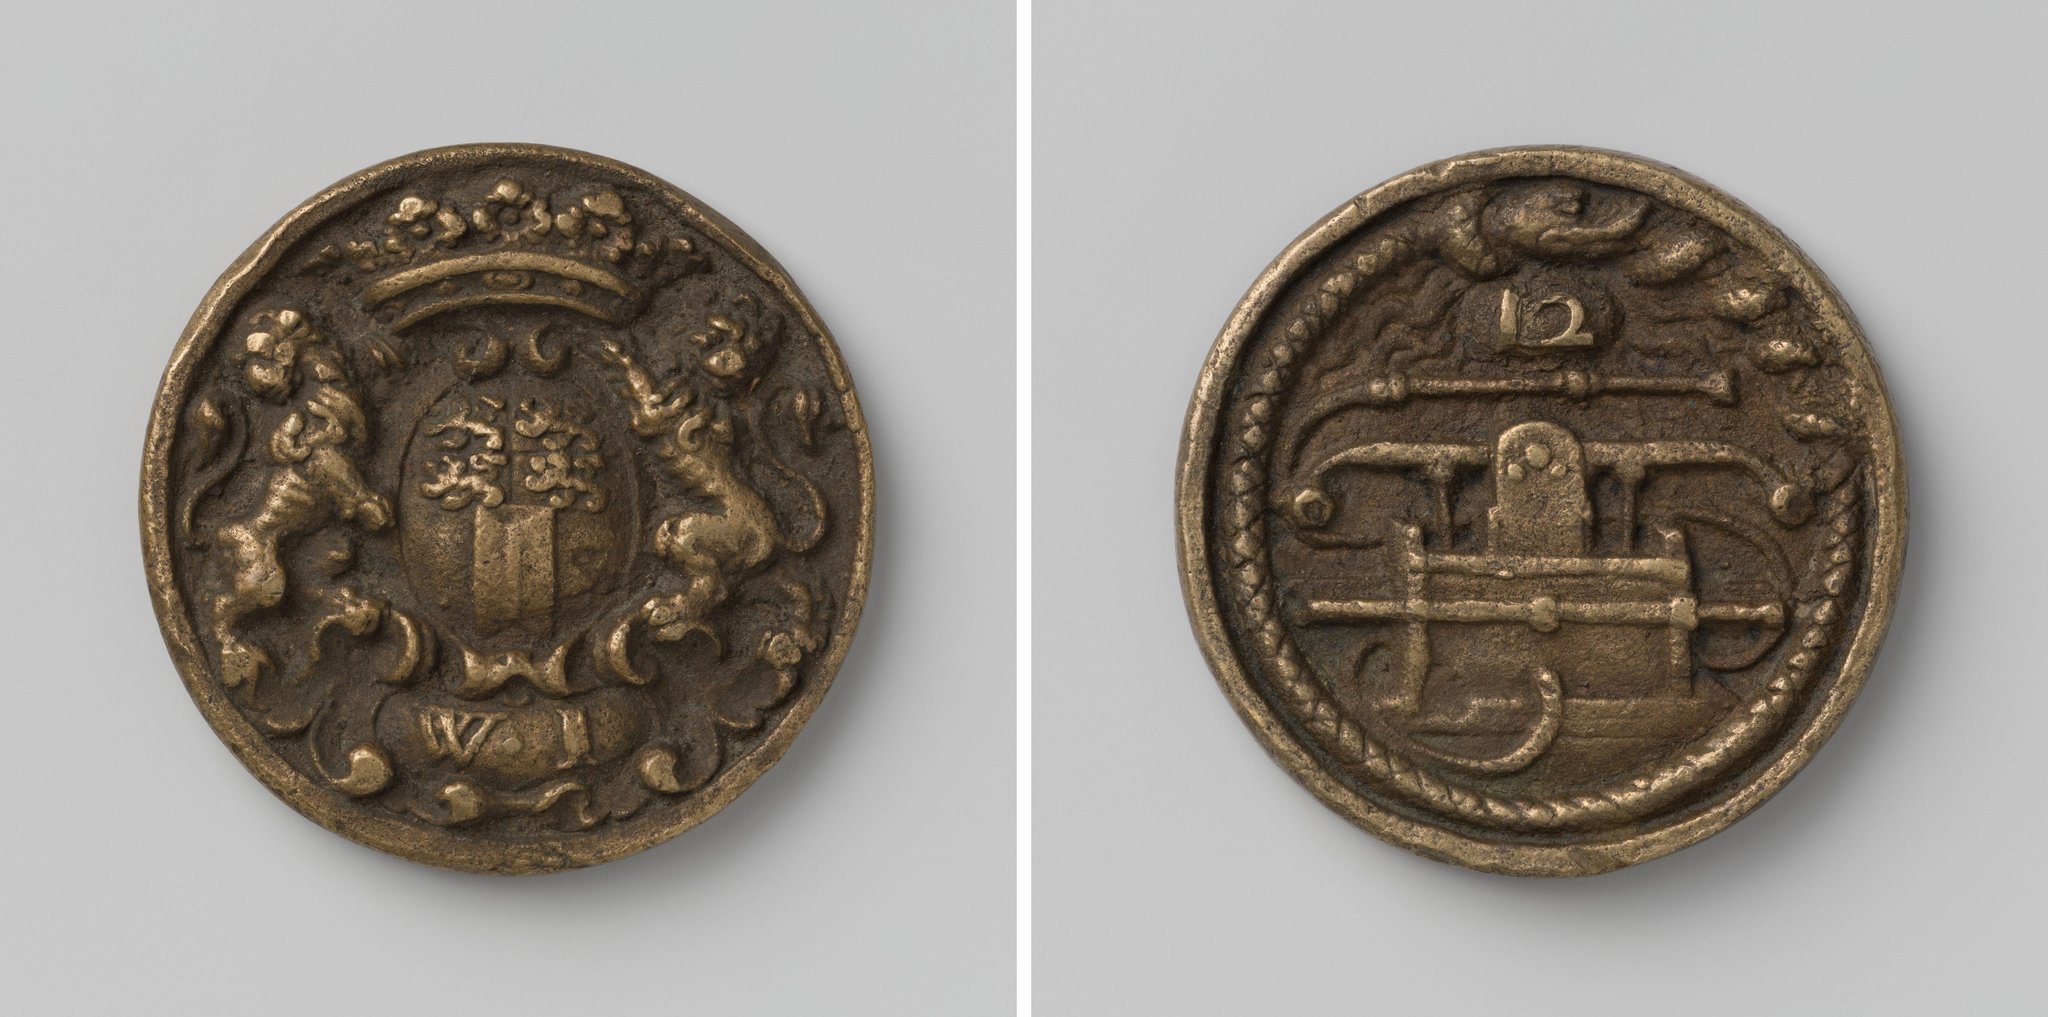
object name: fire engine medal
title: Rotterdam, brandspuitpenning van wijk 1 met no. 12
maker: Anonymous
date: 1680-1800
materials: brass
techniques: casting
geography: rotterdam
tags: rotterdam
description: Messing penning. Voorzijde: gekroond wapenschild geflankeerd door twee leeuwen boven cartouche met opschrift w 1. Keerzijde: brandspuit onder cartouche met cijfer 12 binnen slangerond